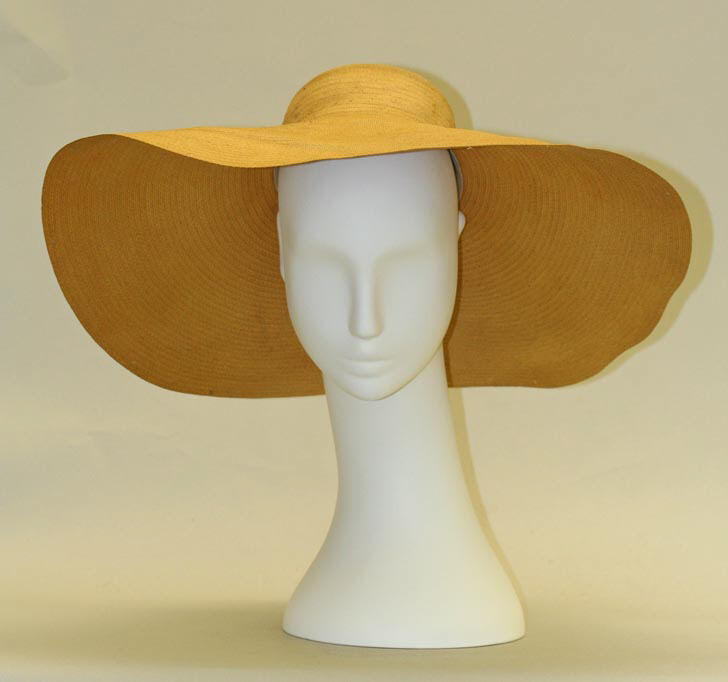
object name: hat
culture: american or european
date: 1801-1833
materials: fiber